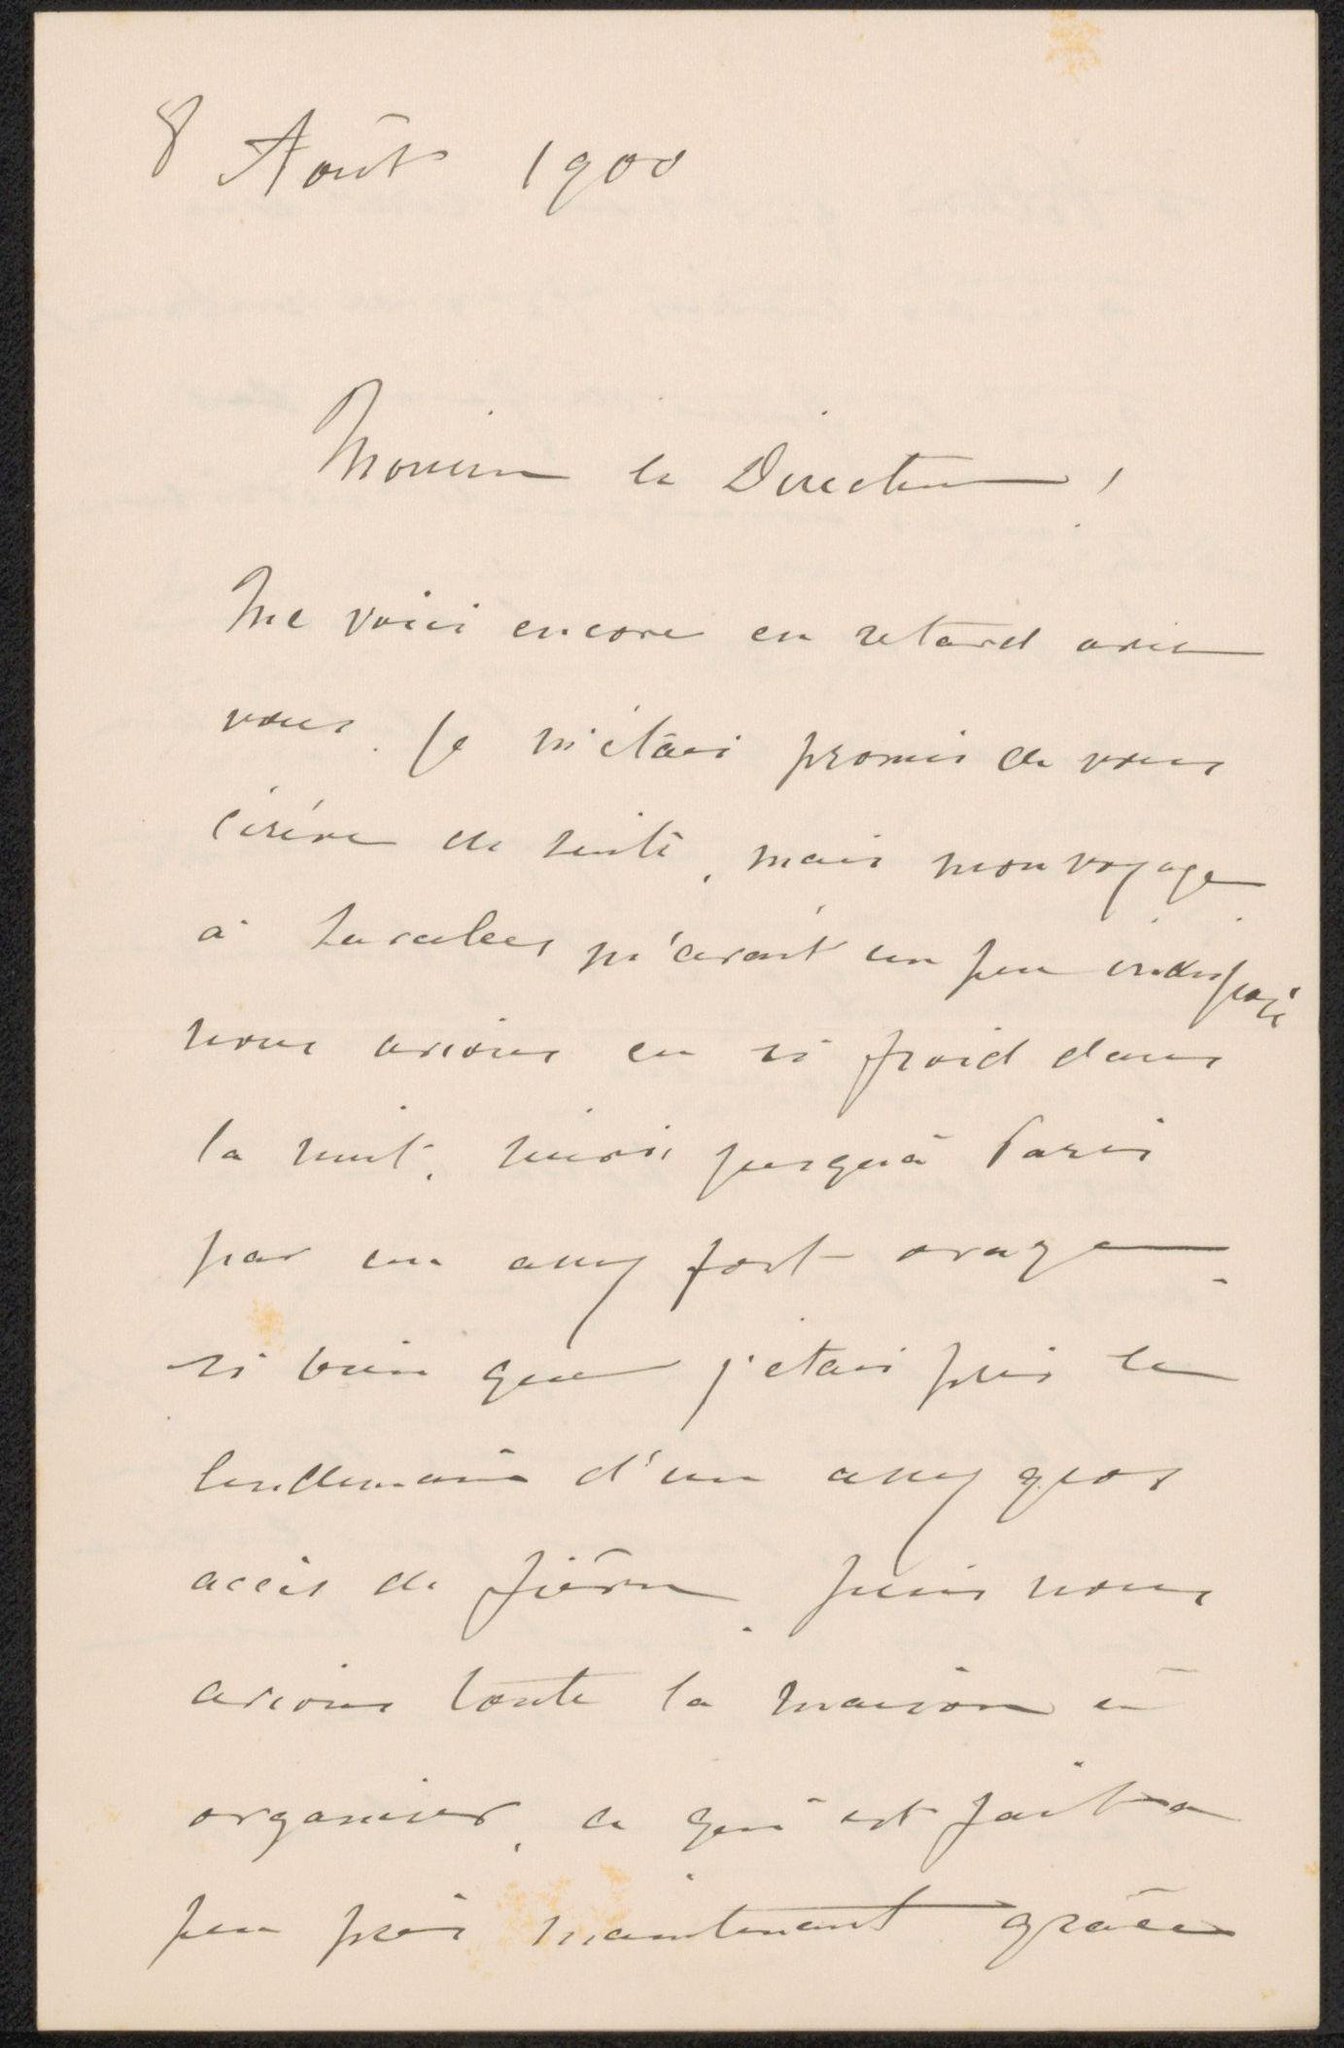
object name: letter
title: Brief aan August Allebé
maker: ferdinand leenhoff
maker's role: print maker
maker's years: 1841-1914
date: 1900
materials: ink, paper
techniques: pen, writing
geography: sarcelles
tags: august allebé, rome, draughtsman, designer, sculptor, pier pander, sculpture, workshop, studio of the artist (in general)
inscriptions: watermark